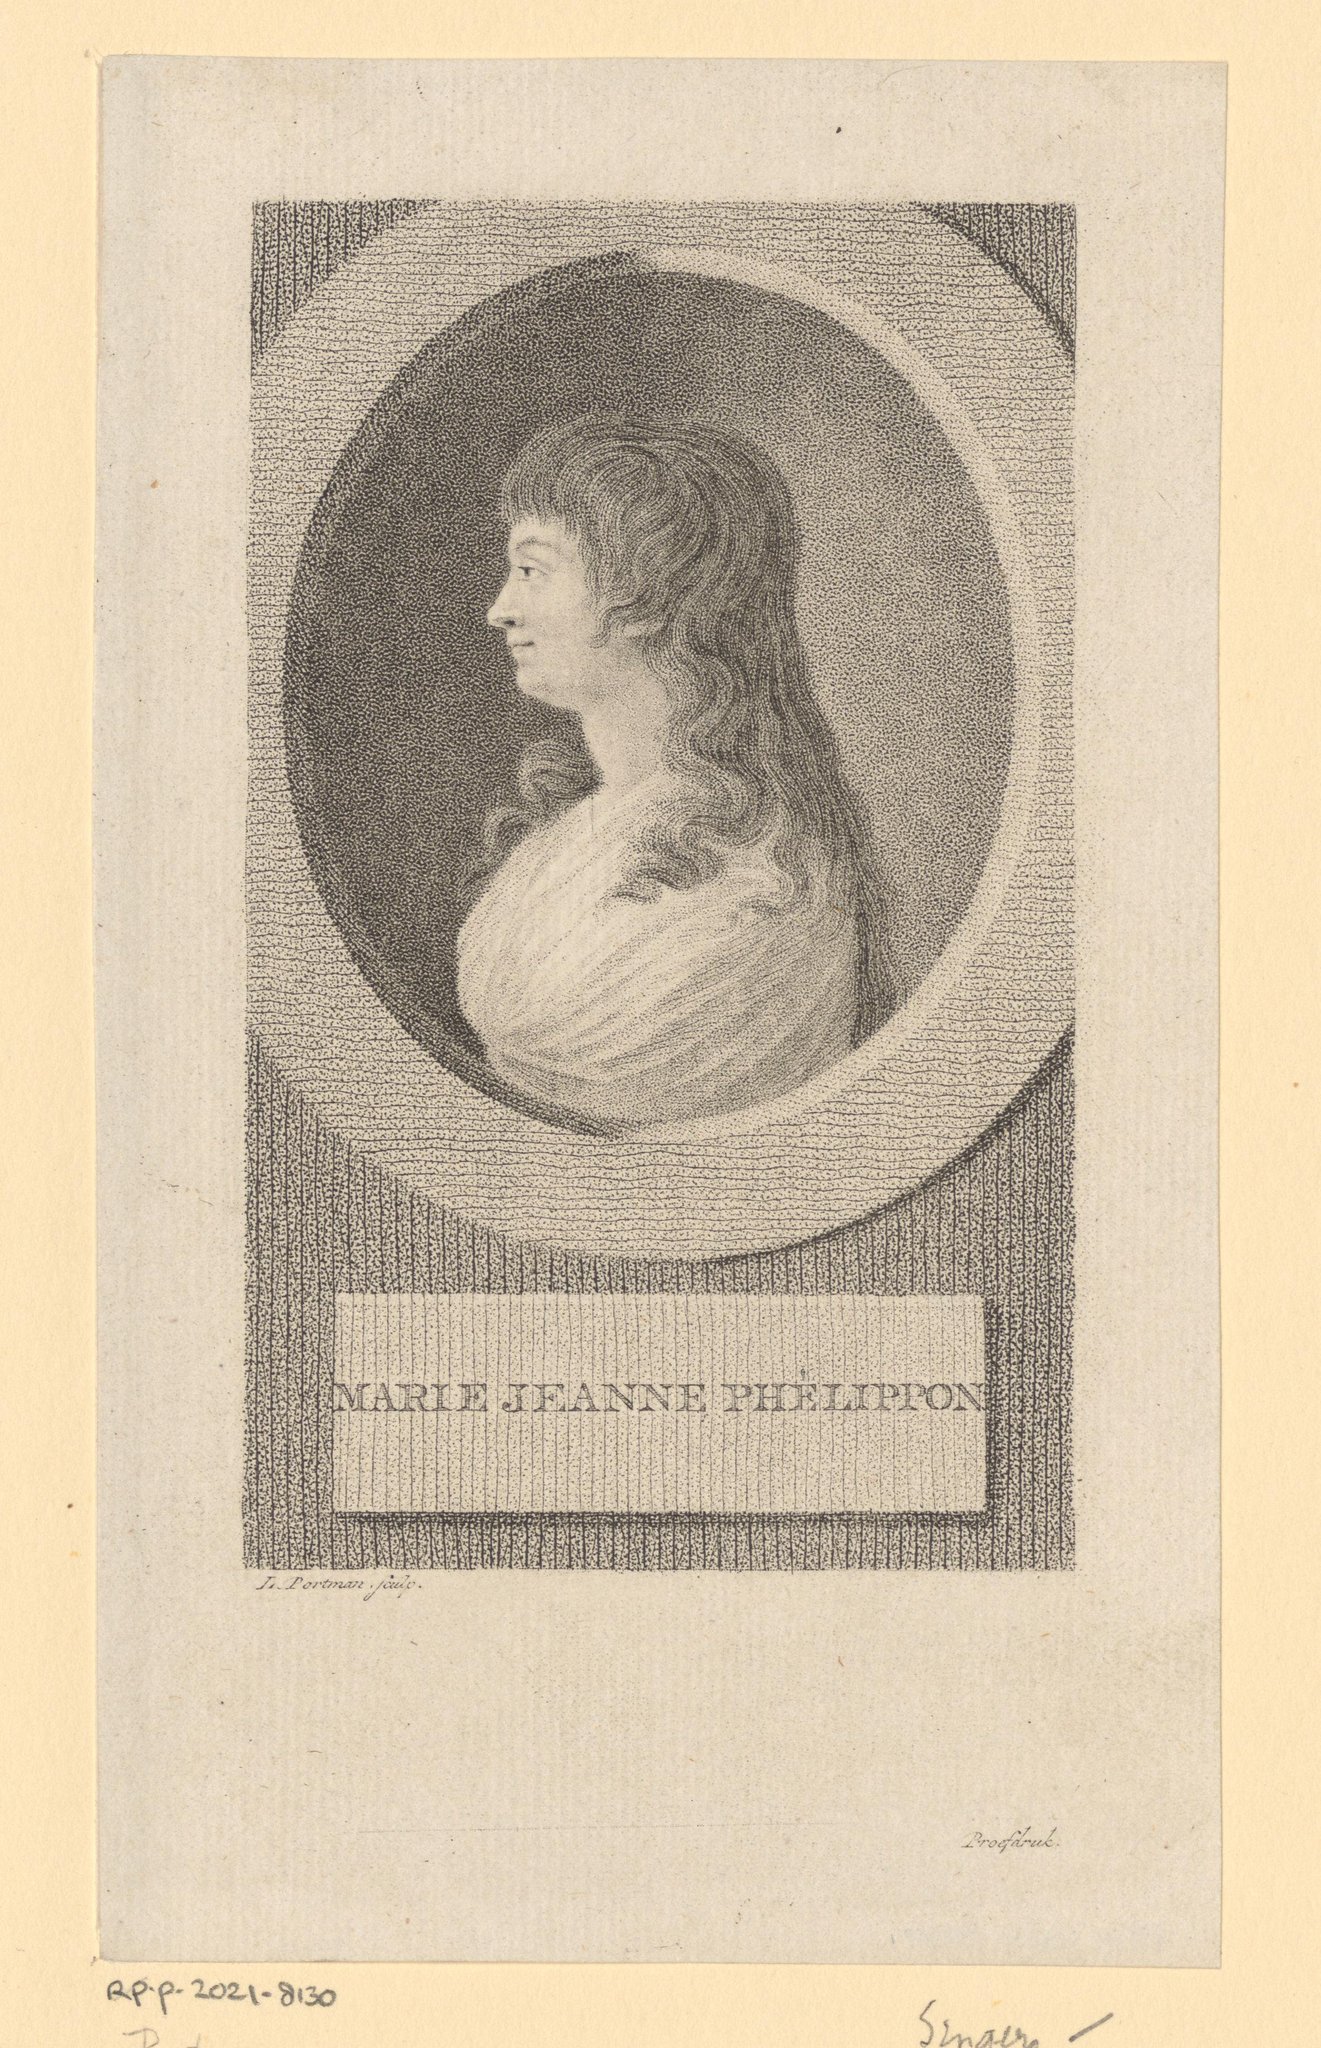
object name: print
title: Portret van Marie-Jeanne Roland de la Platière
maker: ludwig gottlieb portman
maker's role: print maker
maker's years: 1772-1828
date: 1804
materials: paper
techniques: engraving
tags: paris, adult woman, historical persons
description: Andere staat (met tekst, zonder 'proefdruk') van prent gebruikt in: Tafereelen van de staatsomwenteling in Frankrijk. Amsterdam: Johannes Allart, 1804, dl. 18, p. 32.